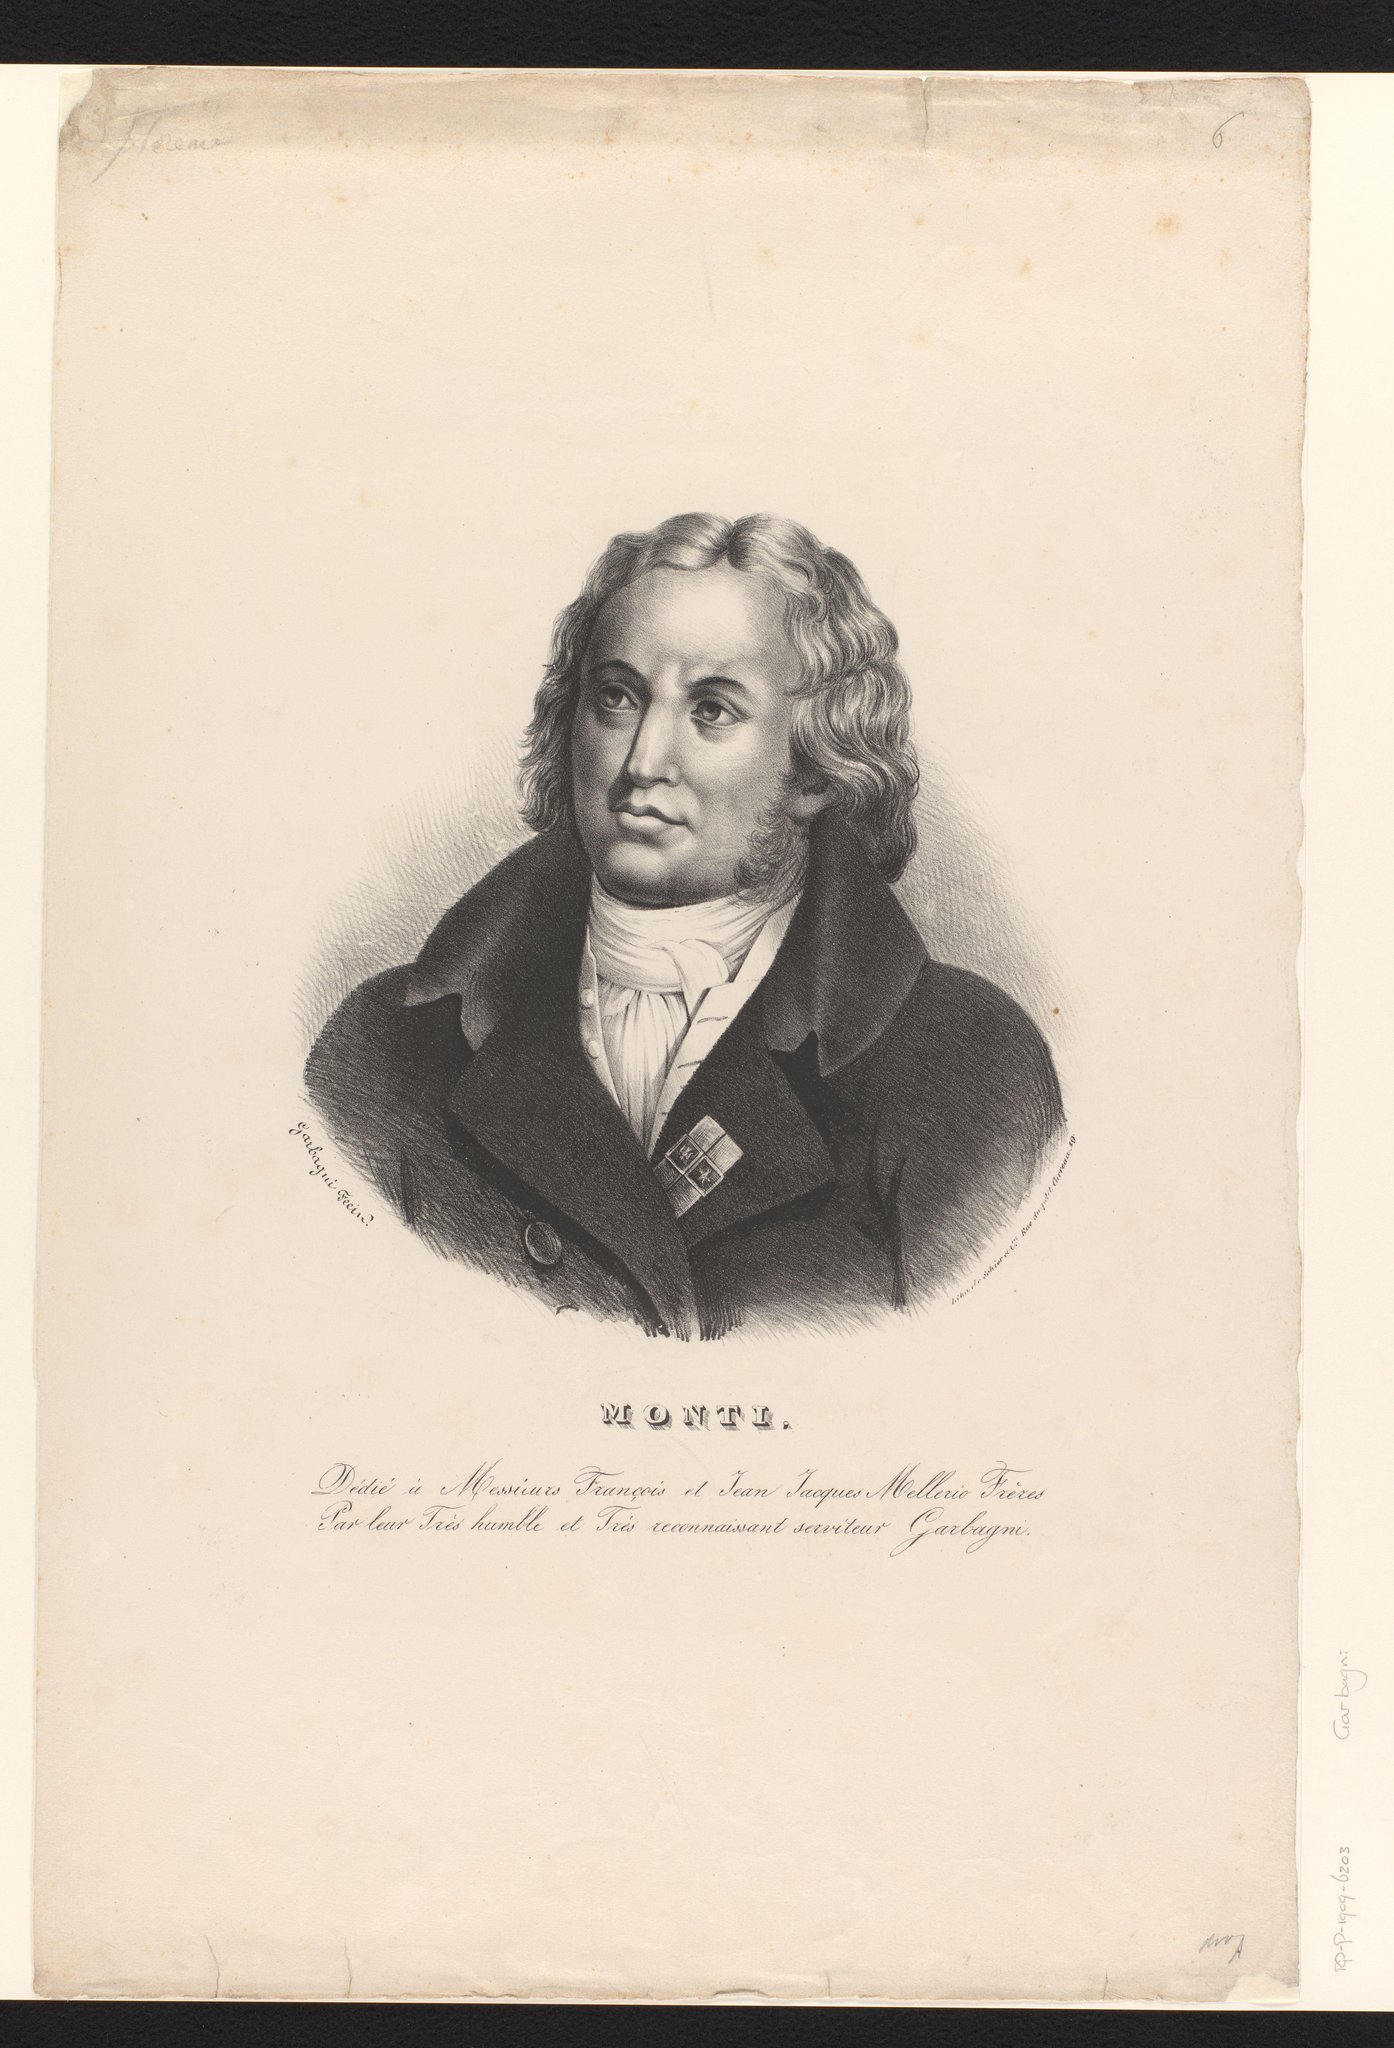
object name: print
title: Portret van de heer Monti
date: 1824-1830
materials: paper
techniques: lithograph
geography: italy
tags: print maker, monti, historical persons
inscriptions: collector's mark: Lugt 2228